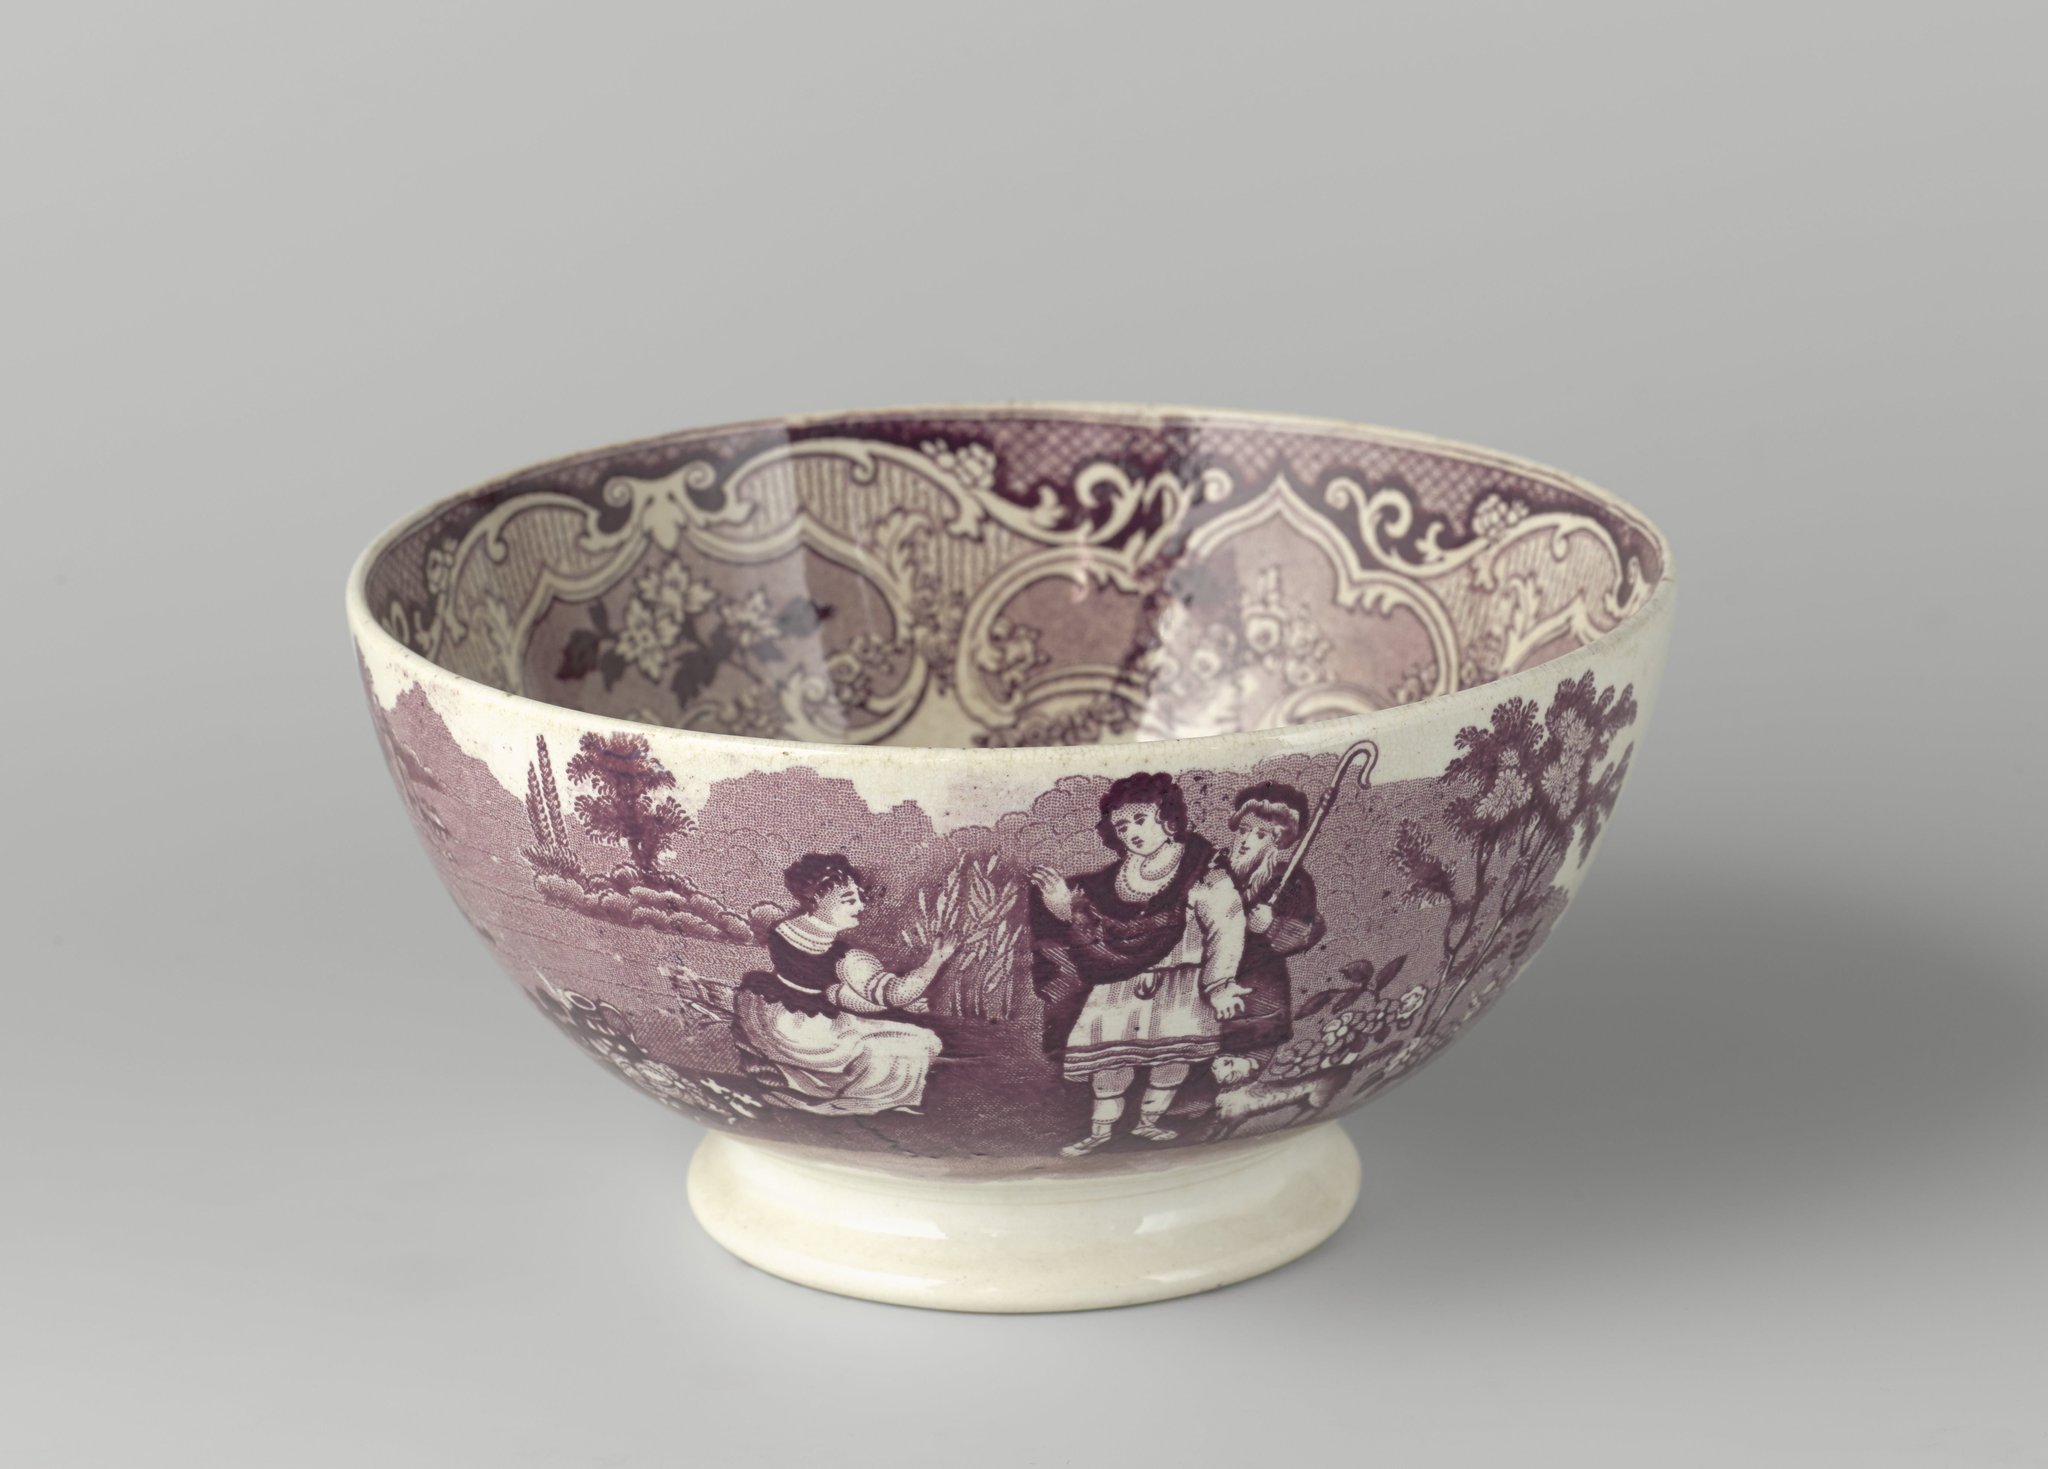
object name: bowl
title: Kom op voet met Ruth en Boaz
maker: petrus regout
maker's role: plateelbakker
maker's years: 1801-1879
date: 1874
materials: earthenware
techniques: transfer decoration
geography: maastricht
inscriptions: check stamp: ‘PR // 7 (?)’, mark: ‘RUTH & BOAZ // MAASTRICHT // PETRUS REGOUT // 7IIII’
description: Kom van aardewerk met paars tranferdecor. Op de buitenzijde van de wand en de bodem van de kom voorstellingen van Ruth en Boaz. De binnenzijde van de wand met cartouches met bloemen.